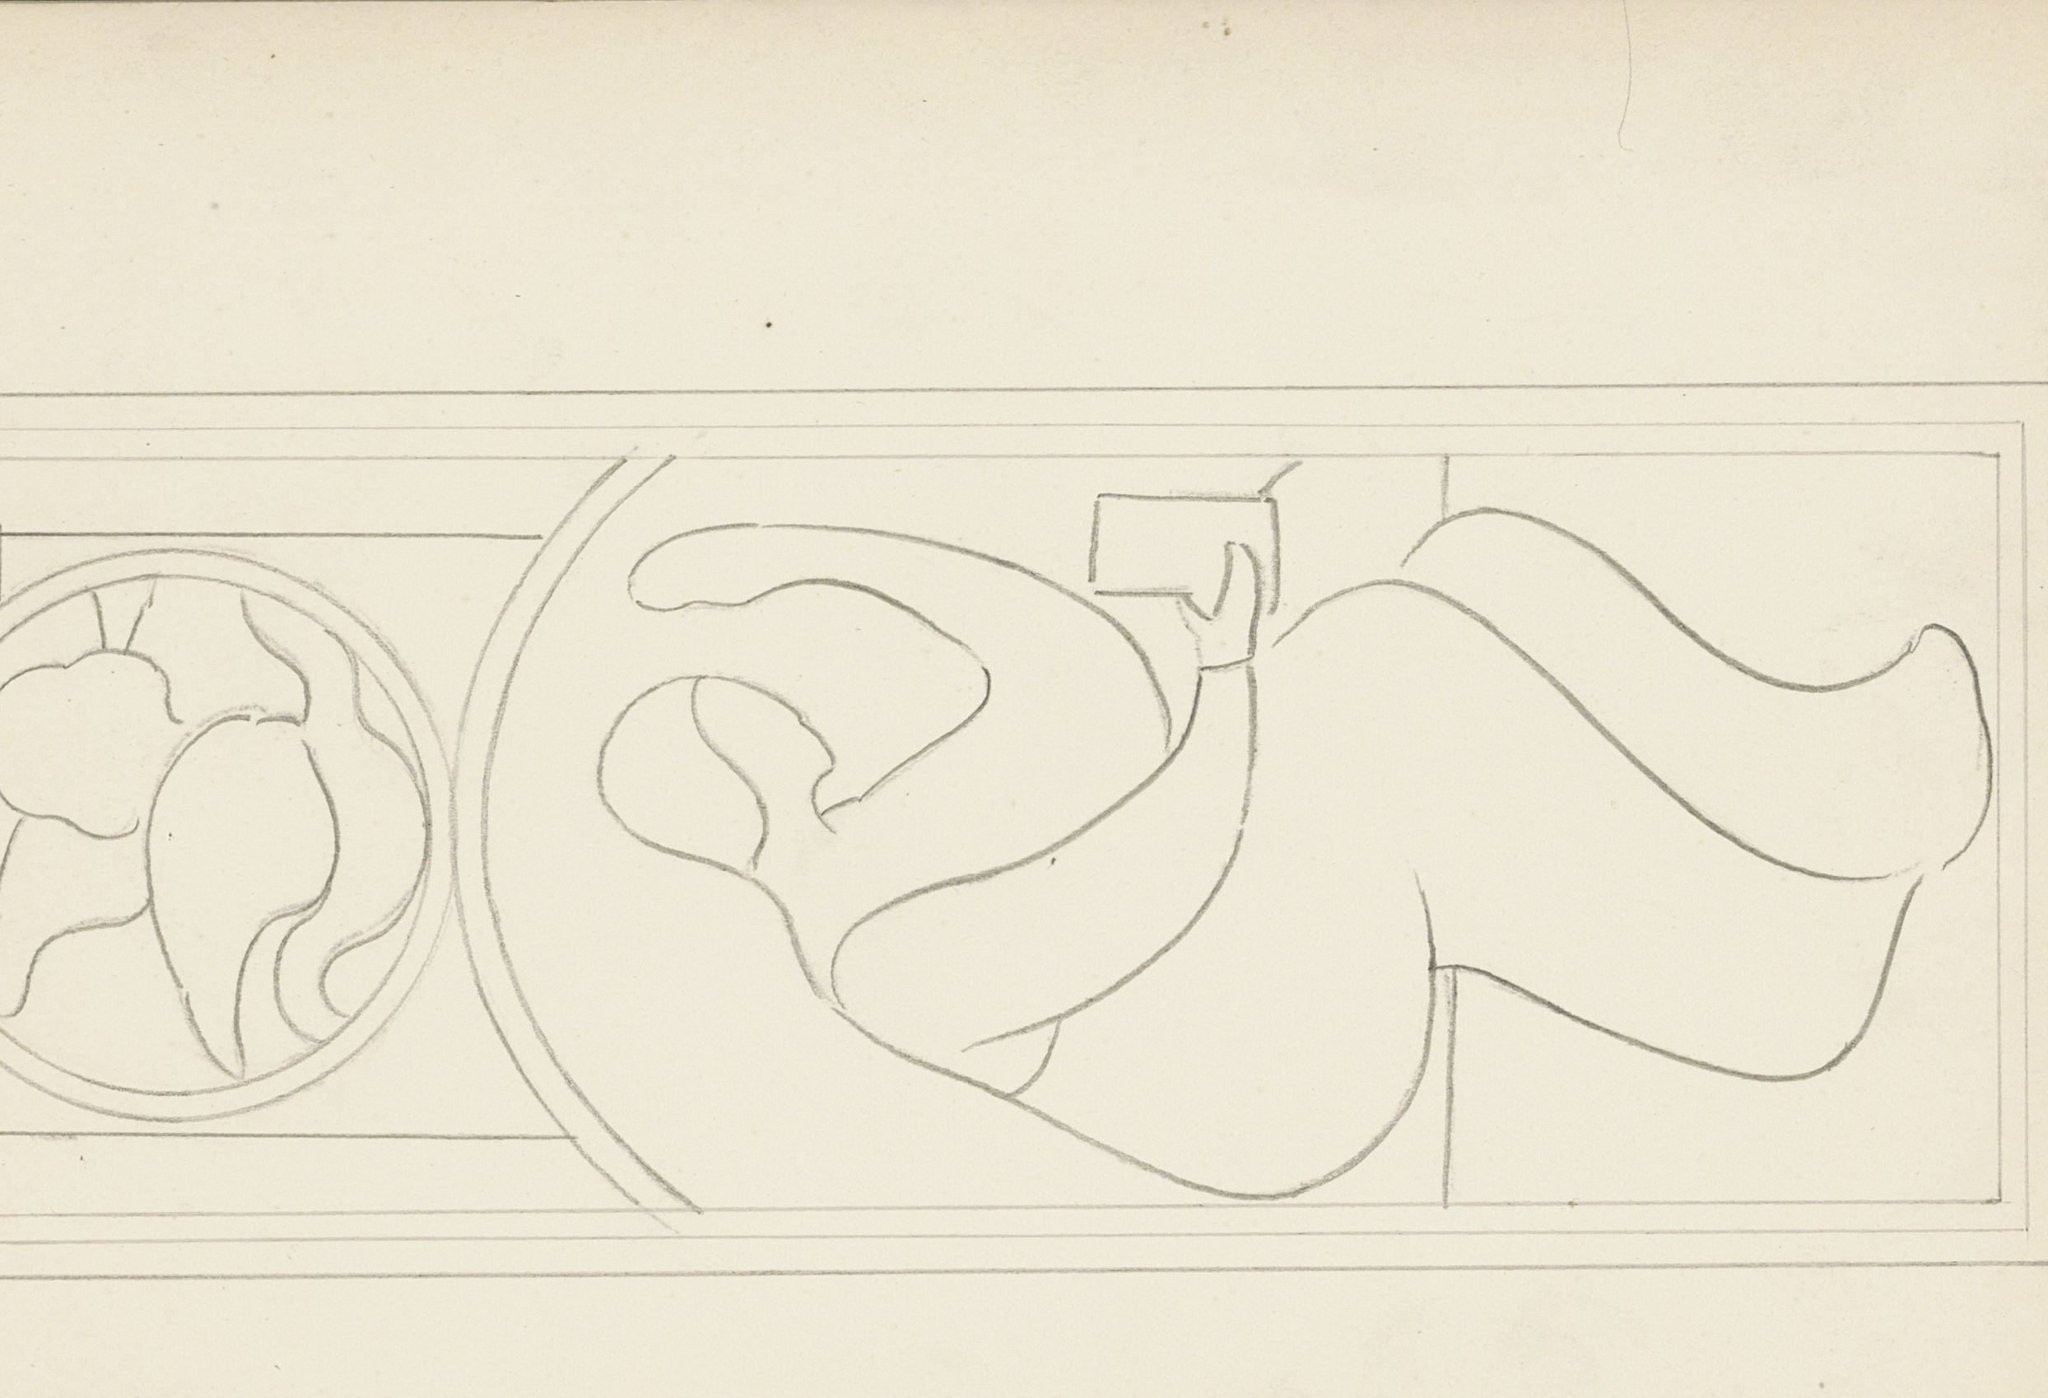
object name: sketchbook leaf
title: Ontwerp voor een venster met een zittende vrouw en putto in een omlijsting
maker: antoon derkinderen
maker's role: draughtsman, painter, print maker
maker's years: 1859-1925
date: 1900-1903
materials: paper, pencil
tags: window, sitting figure - aa - female human figure, cupids: 'amores', 'amoretti', 'putti'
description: De vrouw zit licht voorovergebogen met een voorwerp in haar rechterhand. Boven haar een putto in een medaillon. Ontwerp voor een glas-in-loodraam voor de Kamer van Koophandel in de Beurs van Berlage te Amsterdam. Blad 17 recto uit een schetsboek met 45 bladen.